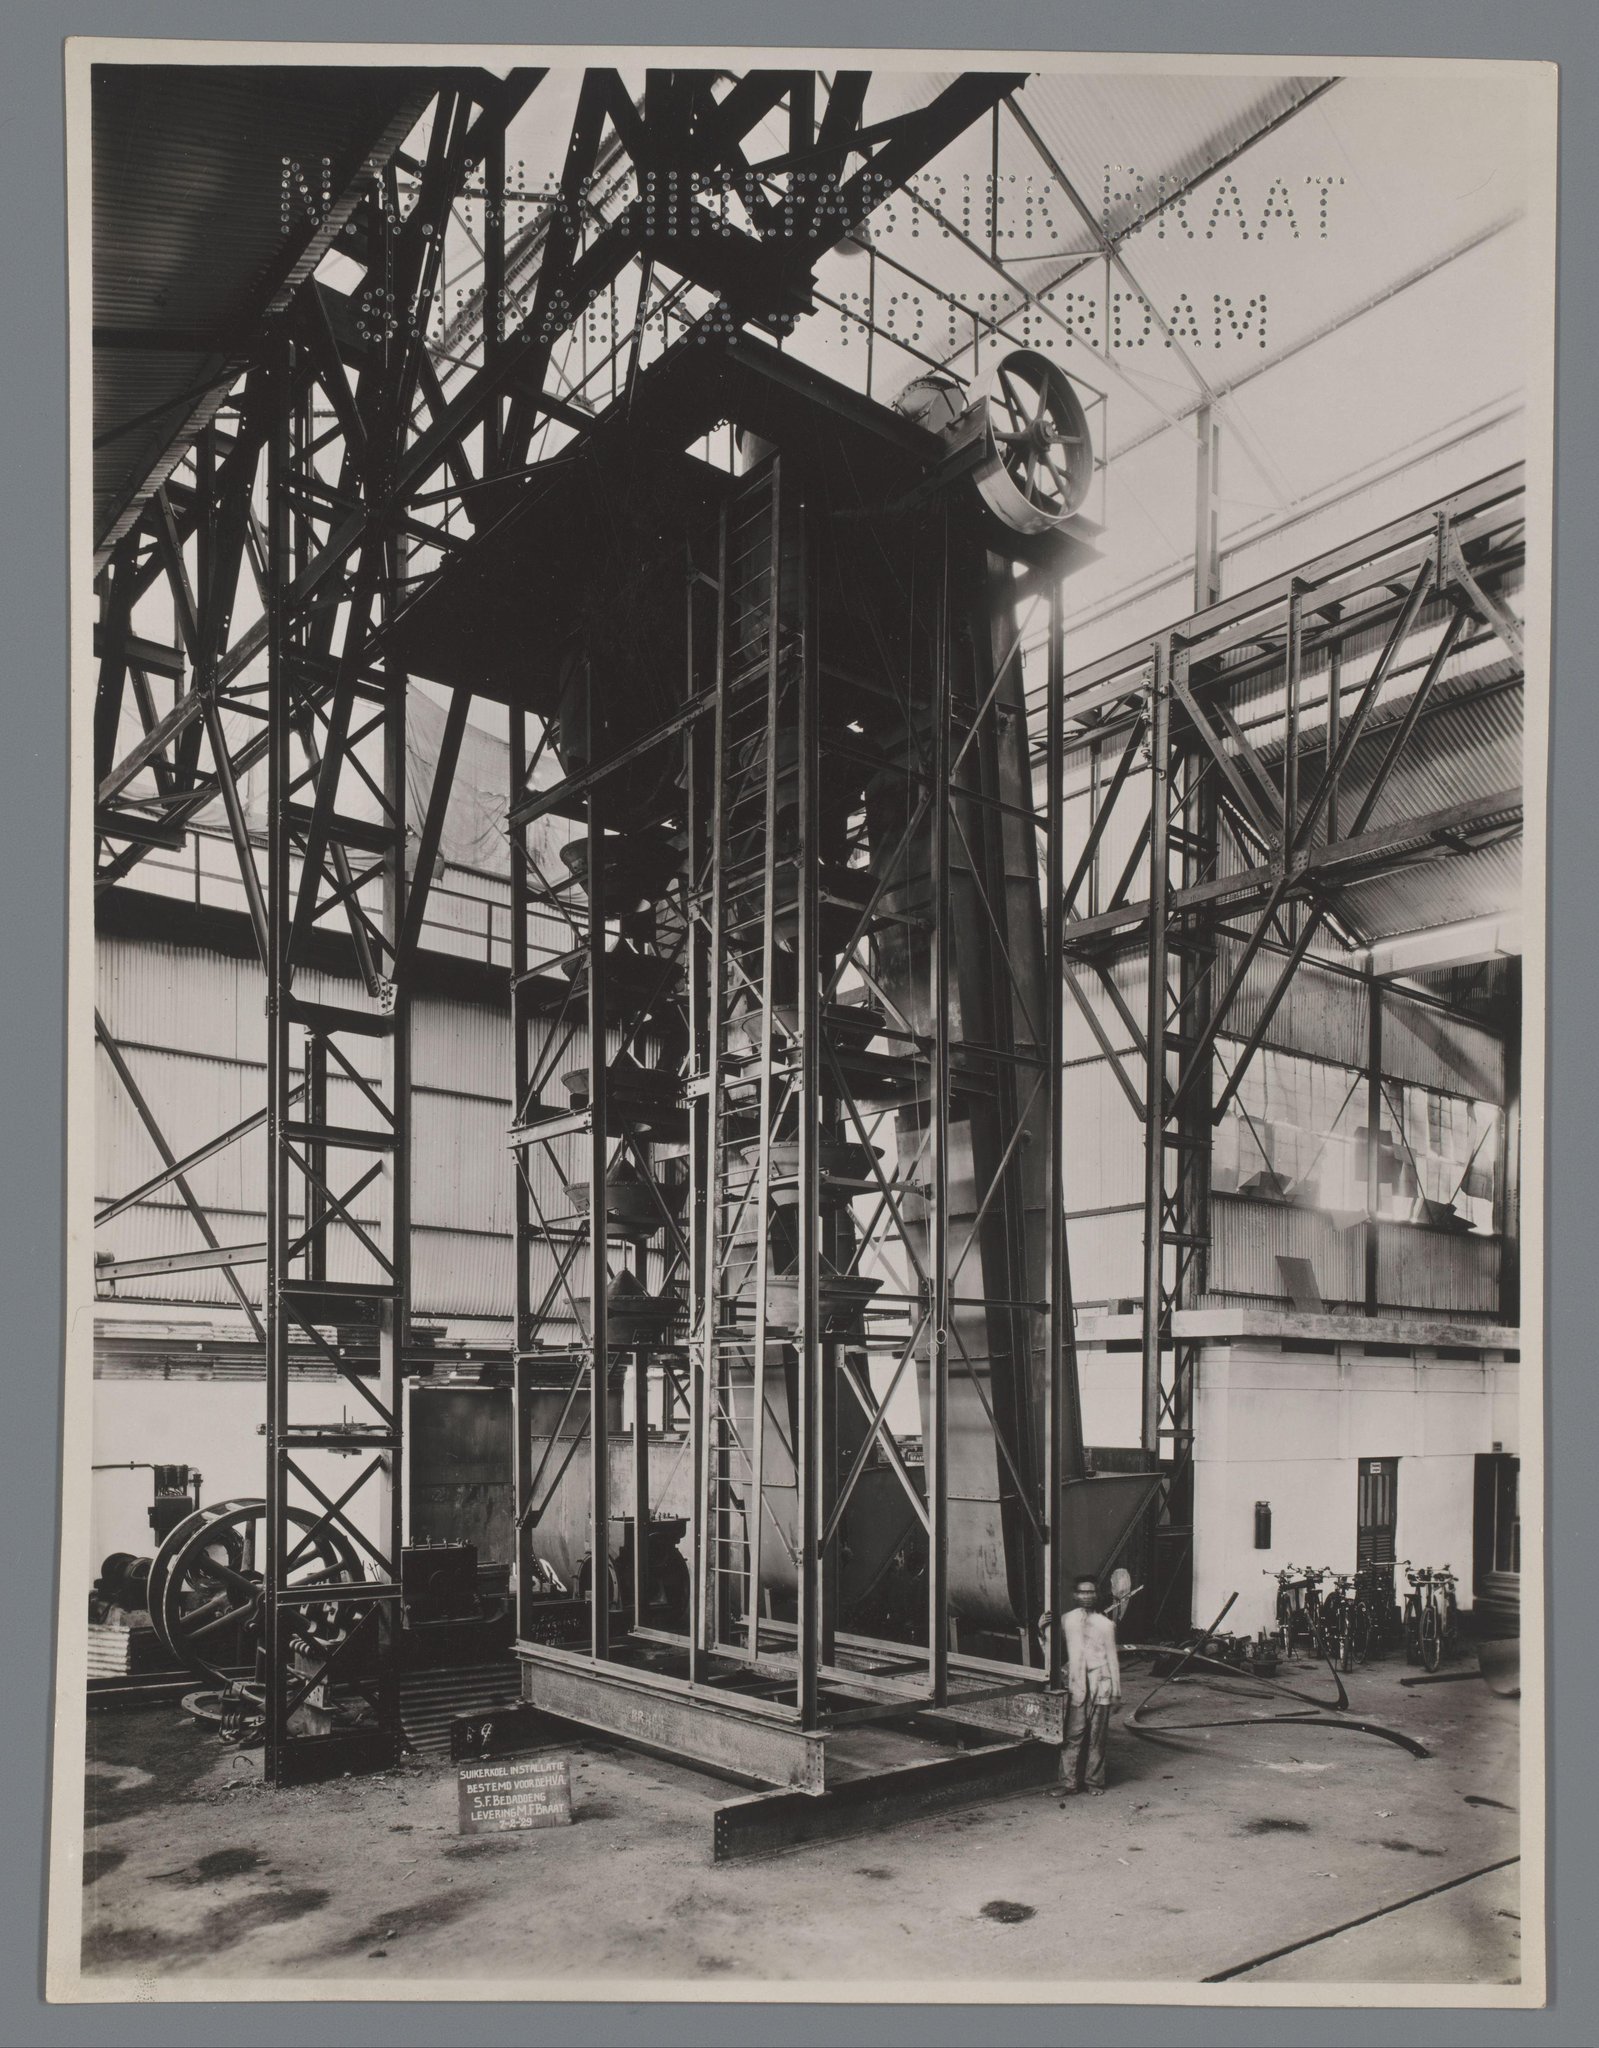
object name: photograph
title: Suiker koelinstallatie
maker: Anonymous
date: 1929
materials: photographic support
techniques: gelatin silver print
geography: surabaya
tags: colonial system, factory-interior, machine shop, machines; parts of machines; tools and appliances, (non-fruit) products of plants or trees: sugarcane, java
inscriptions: company name: ‘N.V. Machinefabriek Braat / Soerabaia – Rotterdam’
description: Koelinstallatie vervaardigd 1929 en bestemd voor de suikerfabriek Bedadoeng. Onderdeel van de multomap met foto's van machines van de N.V. Machinefabriek Braat te Soerabaja bestemd voor de Nederlandse suikerindustrie op Java, uit de periode 1917-1938.